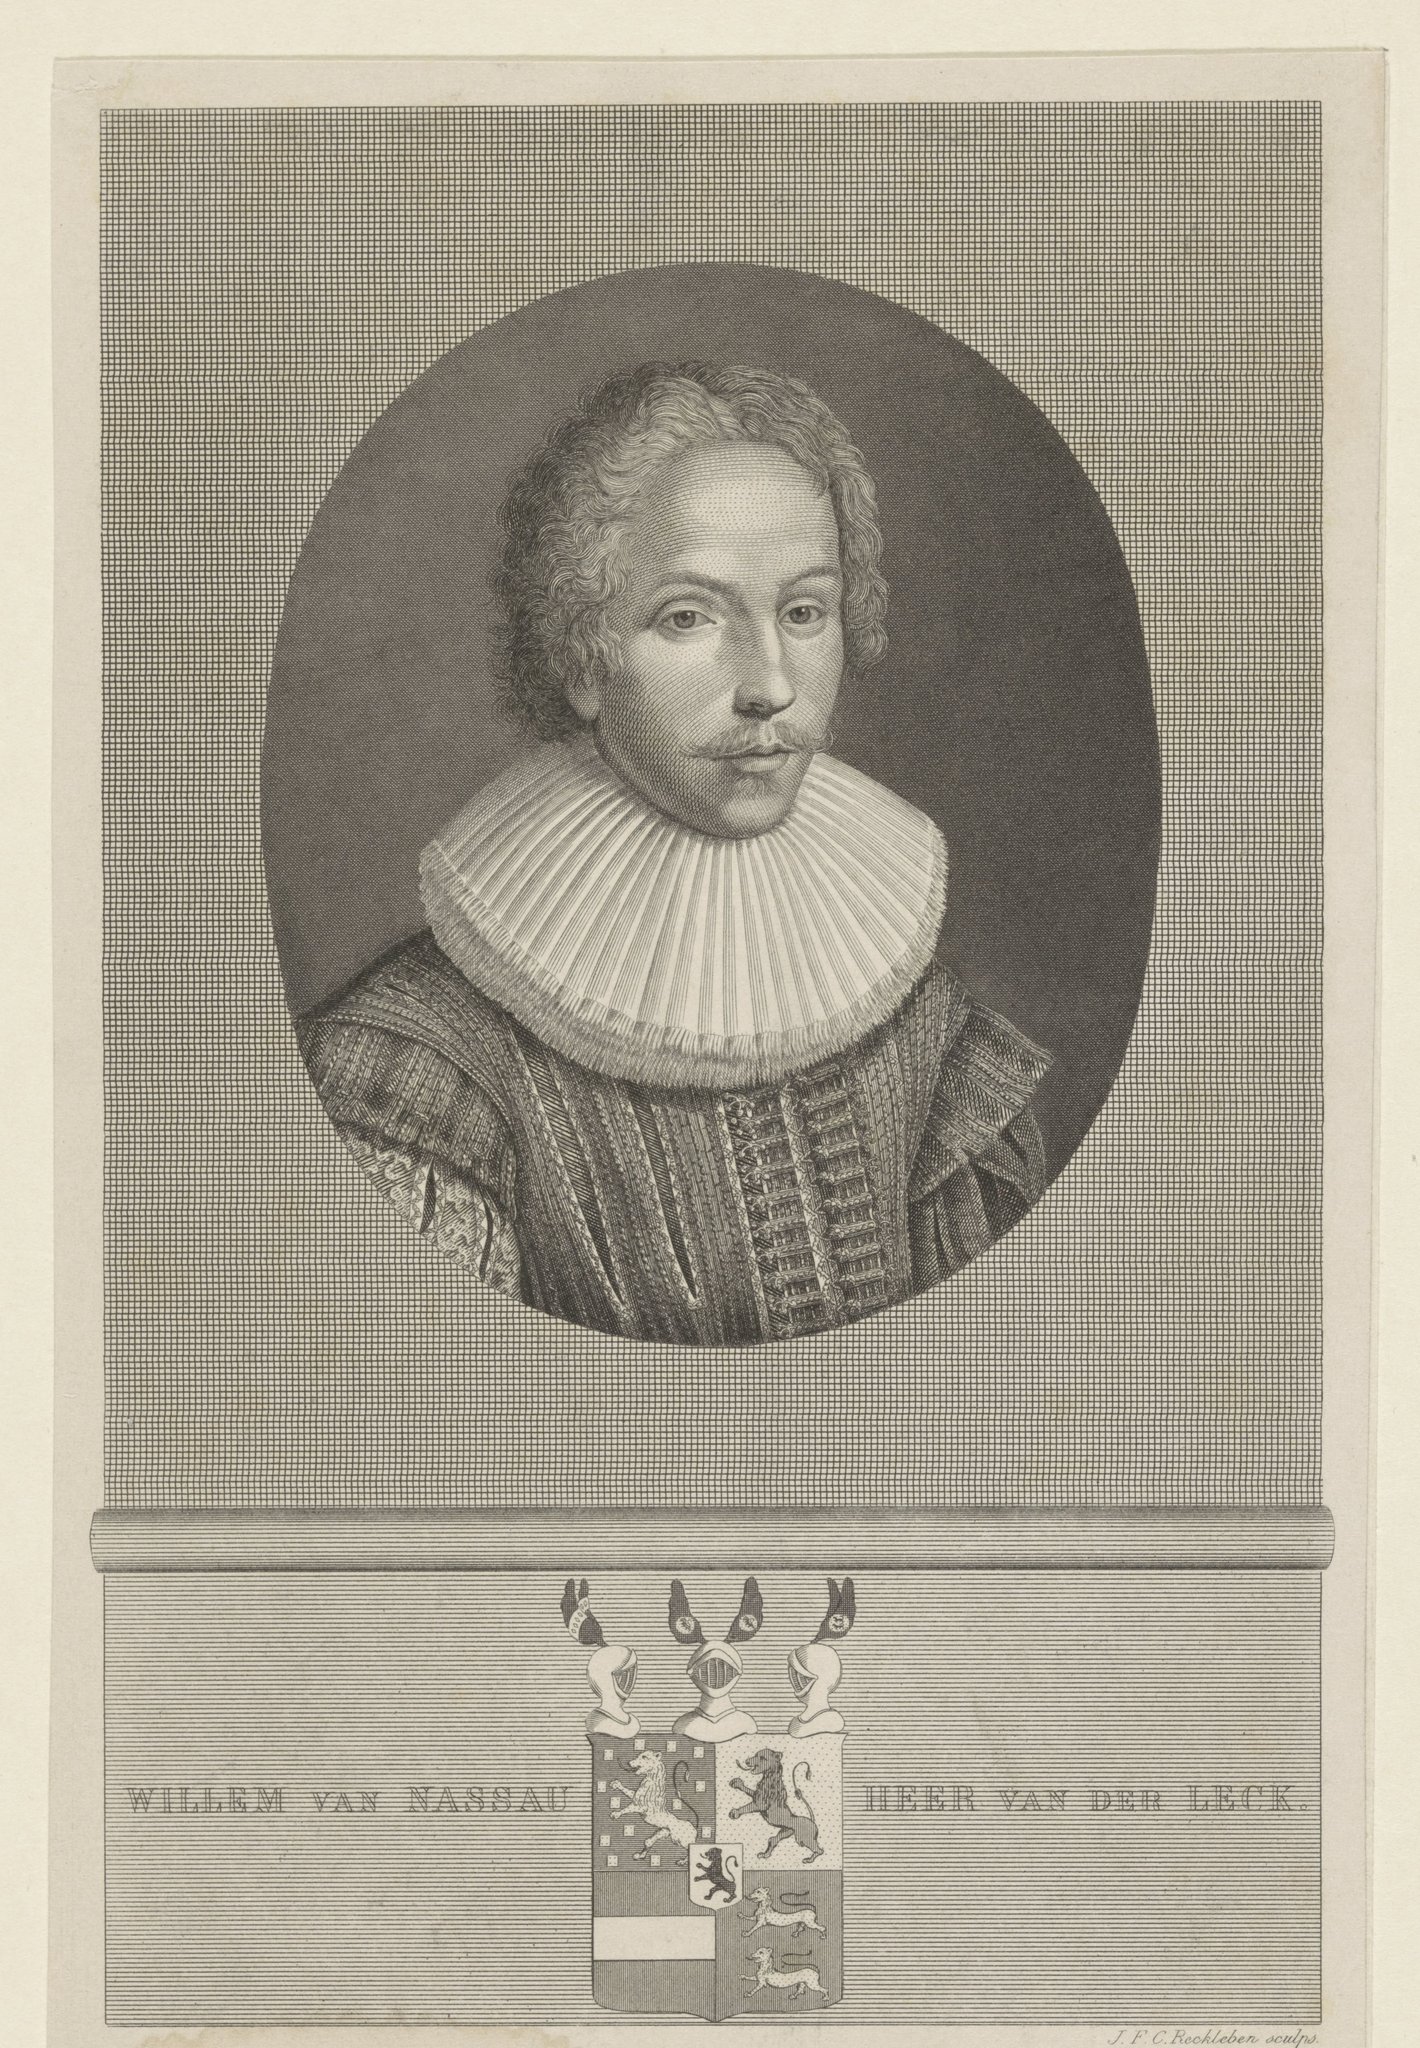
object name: book illustration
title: Portret van Willem van Nassau-LaLecq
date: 1840-1884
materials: paper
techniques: engraving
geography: amsterdam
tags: willem van nassau-lalecq, huis nassau ottoonse linie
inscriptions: collector's mark: Lugt 2228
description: Prent uit: Arend, Johannes Pieter. Algemeene geschiedenis des vaderlands van de vroegste tijden tot op heden. Amsterdam: J.F. Schleijer, 1840-1884.